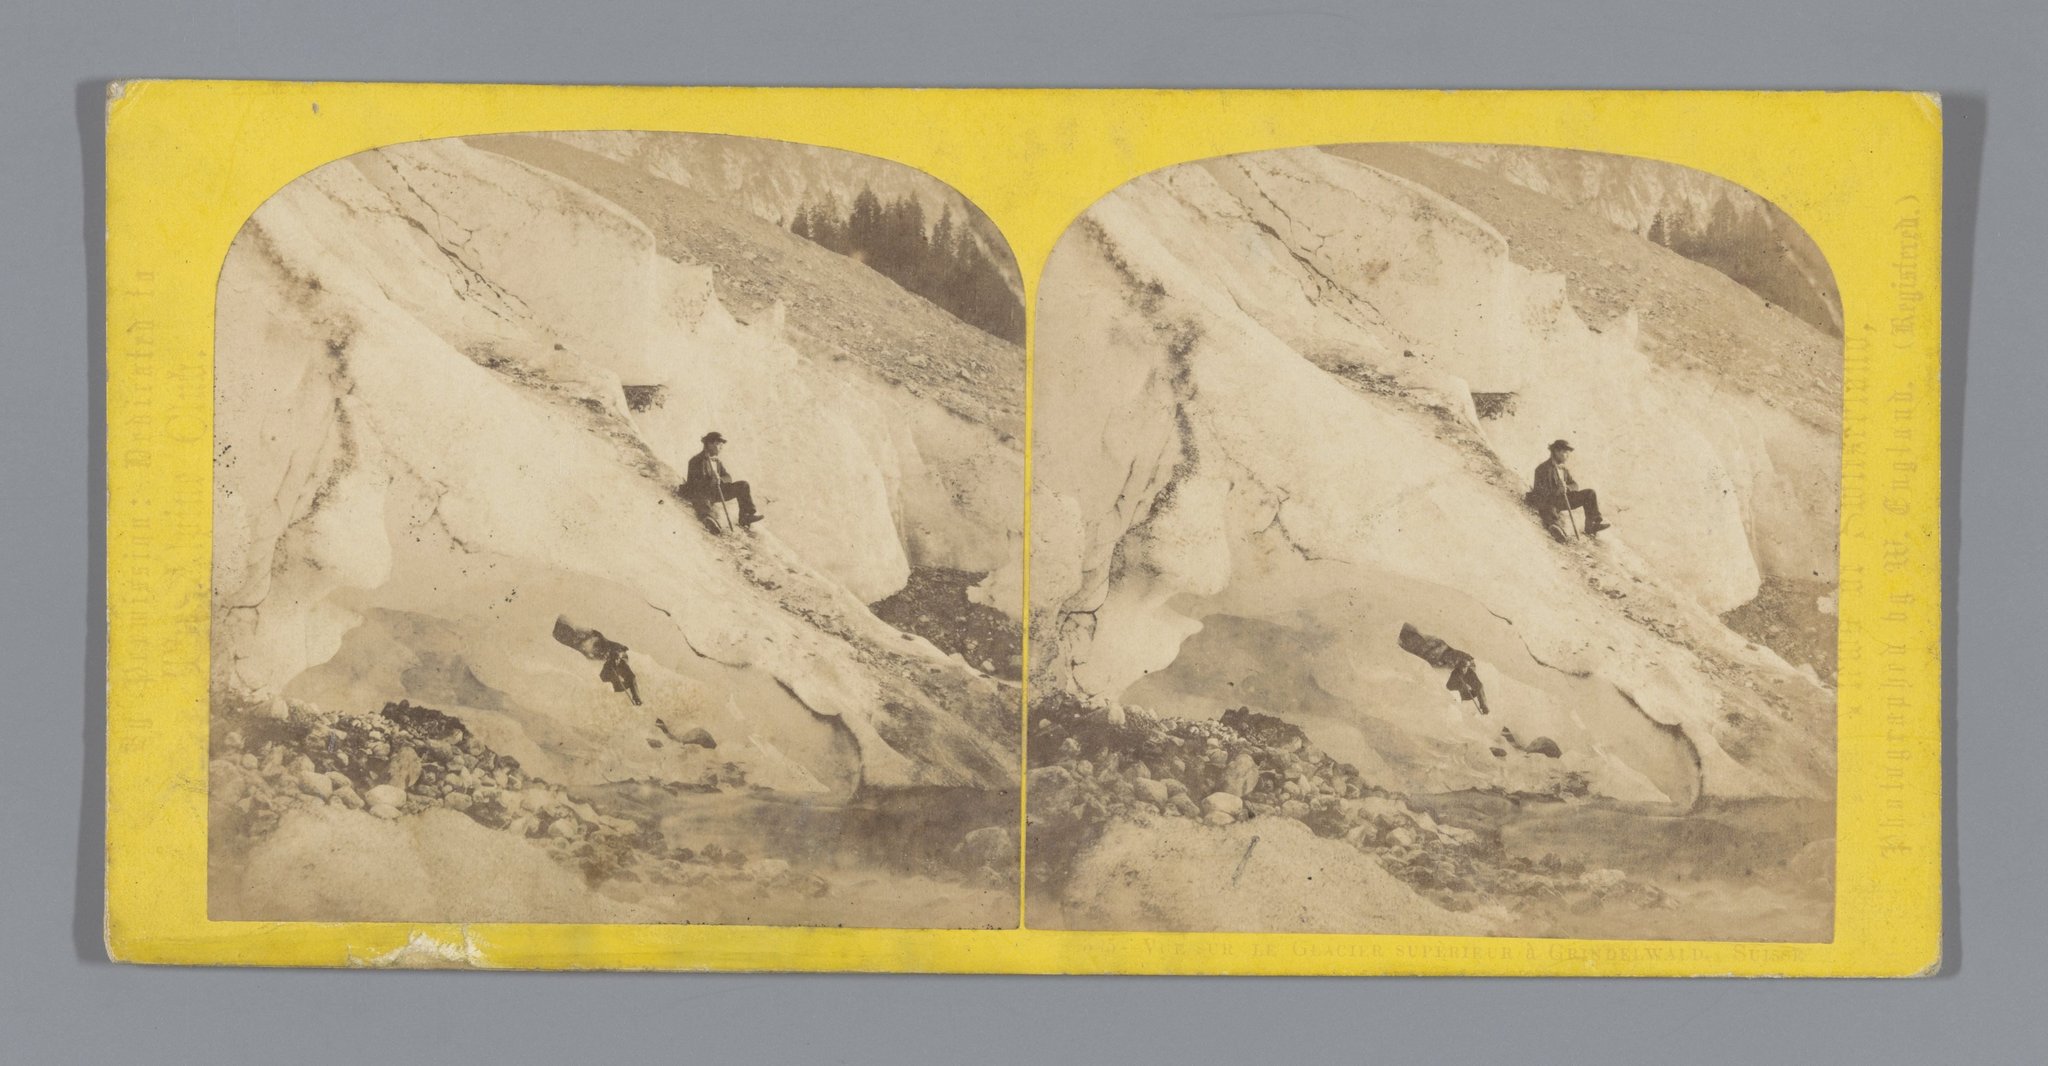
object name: stereograph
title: Gezicht op de Oberer Grindelwaldgletscher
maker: william england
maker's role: fotograaf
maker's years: 1816-1896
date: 1850-1880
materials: cardboard, photographic support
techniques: albumen print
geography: obere grindelwaldgletsjer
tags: glacier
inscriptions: inscription: ‘Views of Switzerland, photographed by W. England. (Registered) Under the Special Patronage of the Alpine Club.’, number: ‘305.’